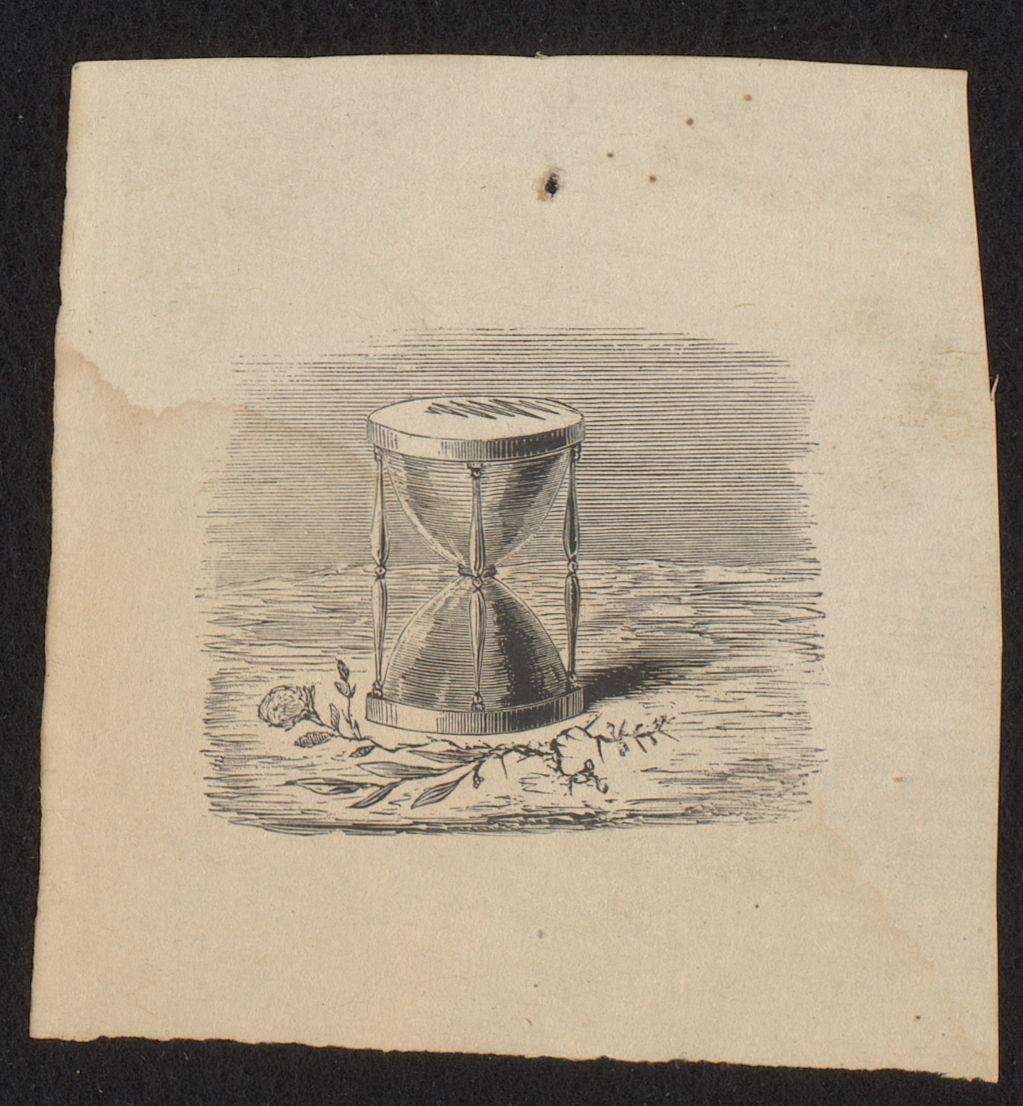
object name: print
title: Zandloper met een verwelkende bloem ervoor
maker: isaac weissenbruch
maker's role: print maker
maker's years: 1826-1912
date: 1836-1912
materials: paper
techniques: engraving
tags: flowers, hourglass